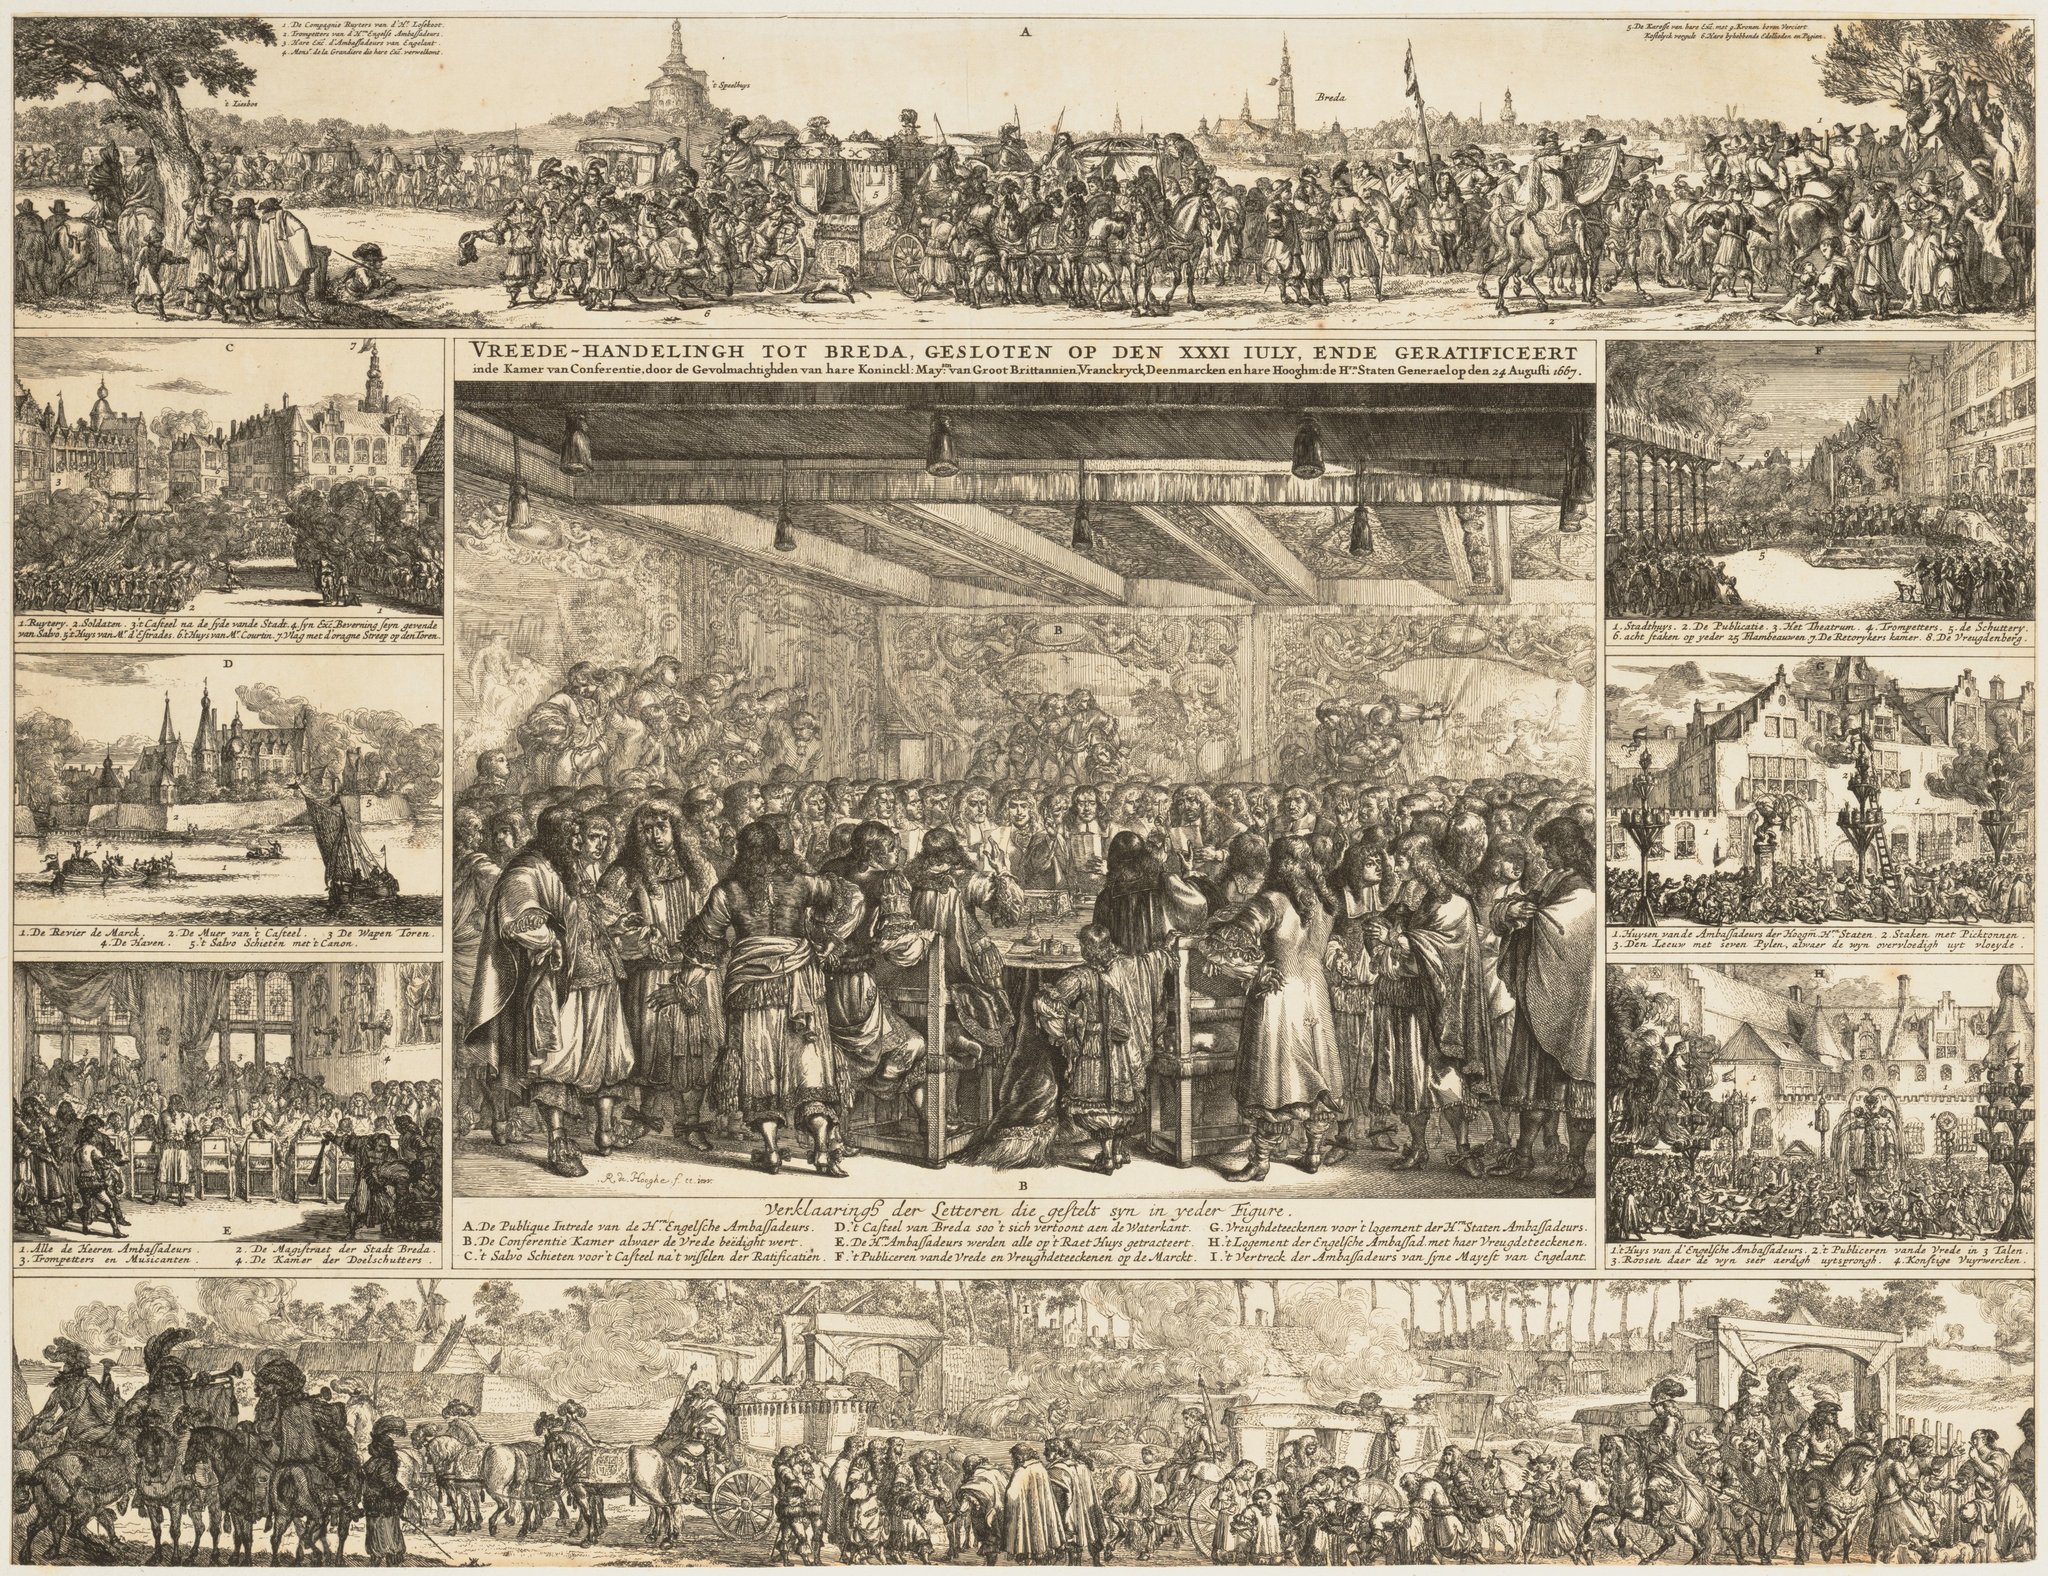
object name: print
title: Peace Conference at Breda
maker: romeyn de hooghe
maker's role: artist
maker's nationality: dutch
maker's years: 1645-1708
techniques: etching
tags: crowd